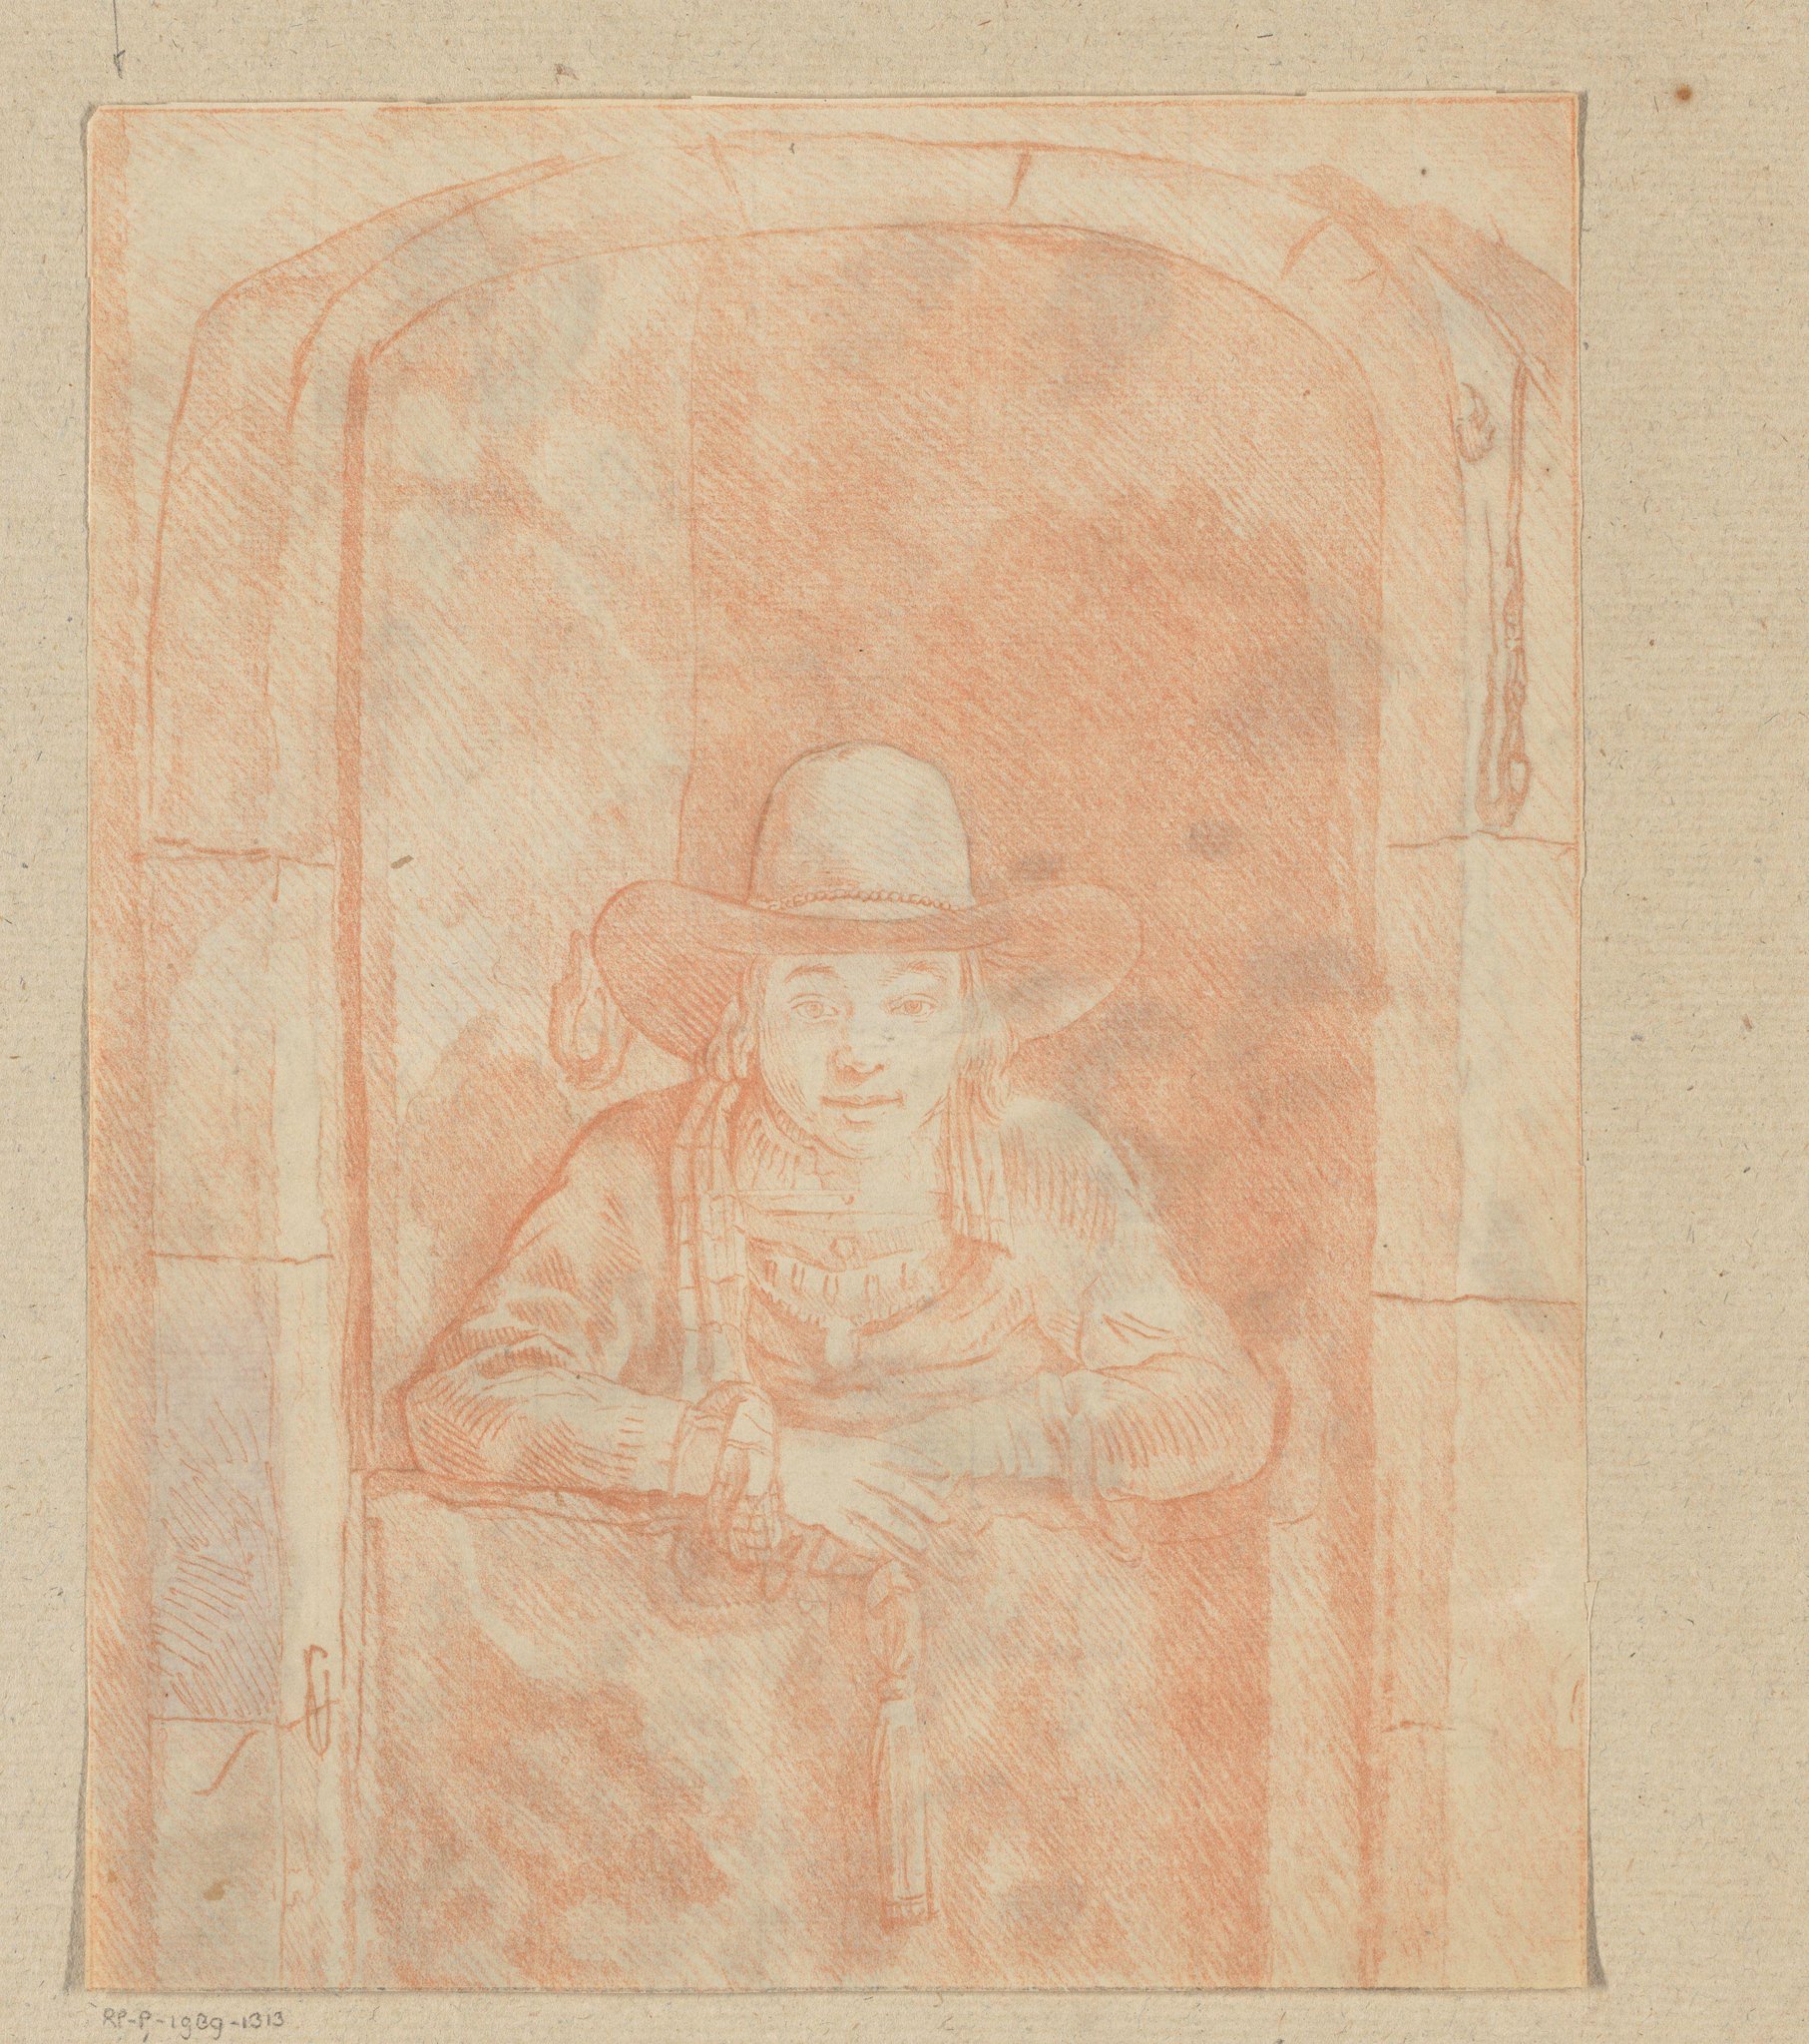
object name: drawing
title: Jongen leunend over een onderdeur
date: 1763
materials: chalk, paper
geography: amsterdam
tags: boy (child between toddler and youth), divided door, upper part opened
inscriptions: collector's mark: ‘RIJKS / MUSM’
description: Een jongen, met een hoed op zijn hoofd, leunt over een onderdeur. De doordruktekening ligt los in een album, zie blad 6.